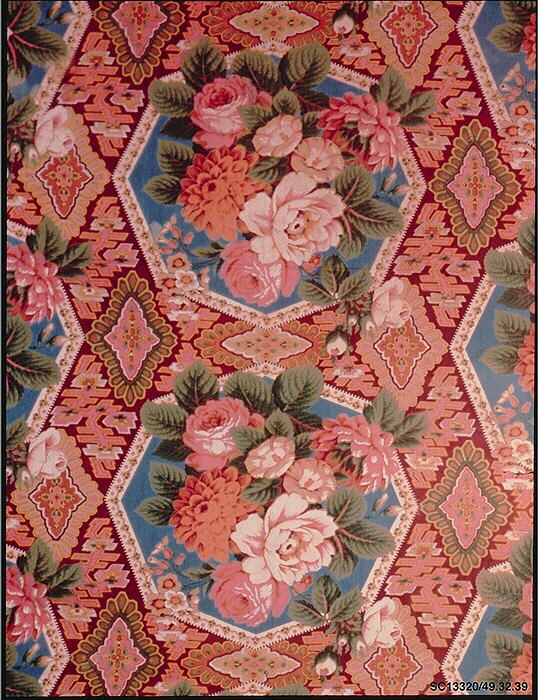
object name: piece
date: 1834-1866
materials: cotton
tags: flowers